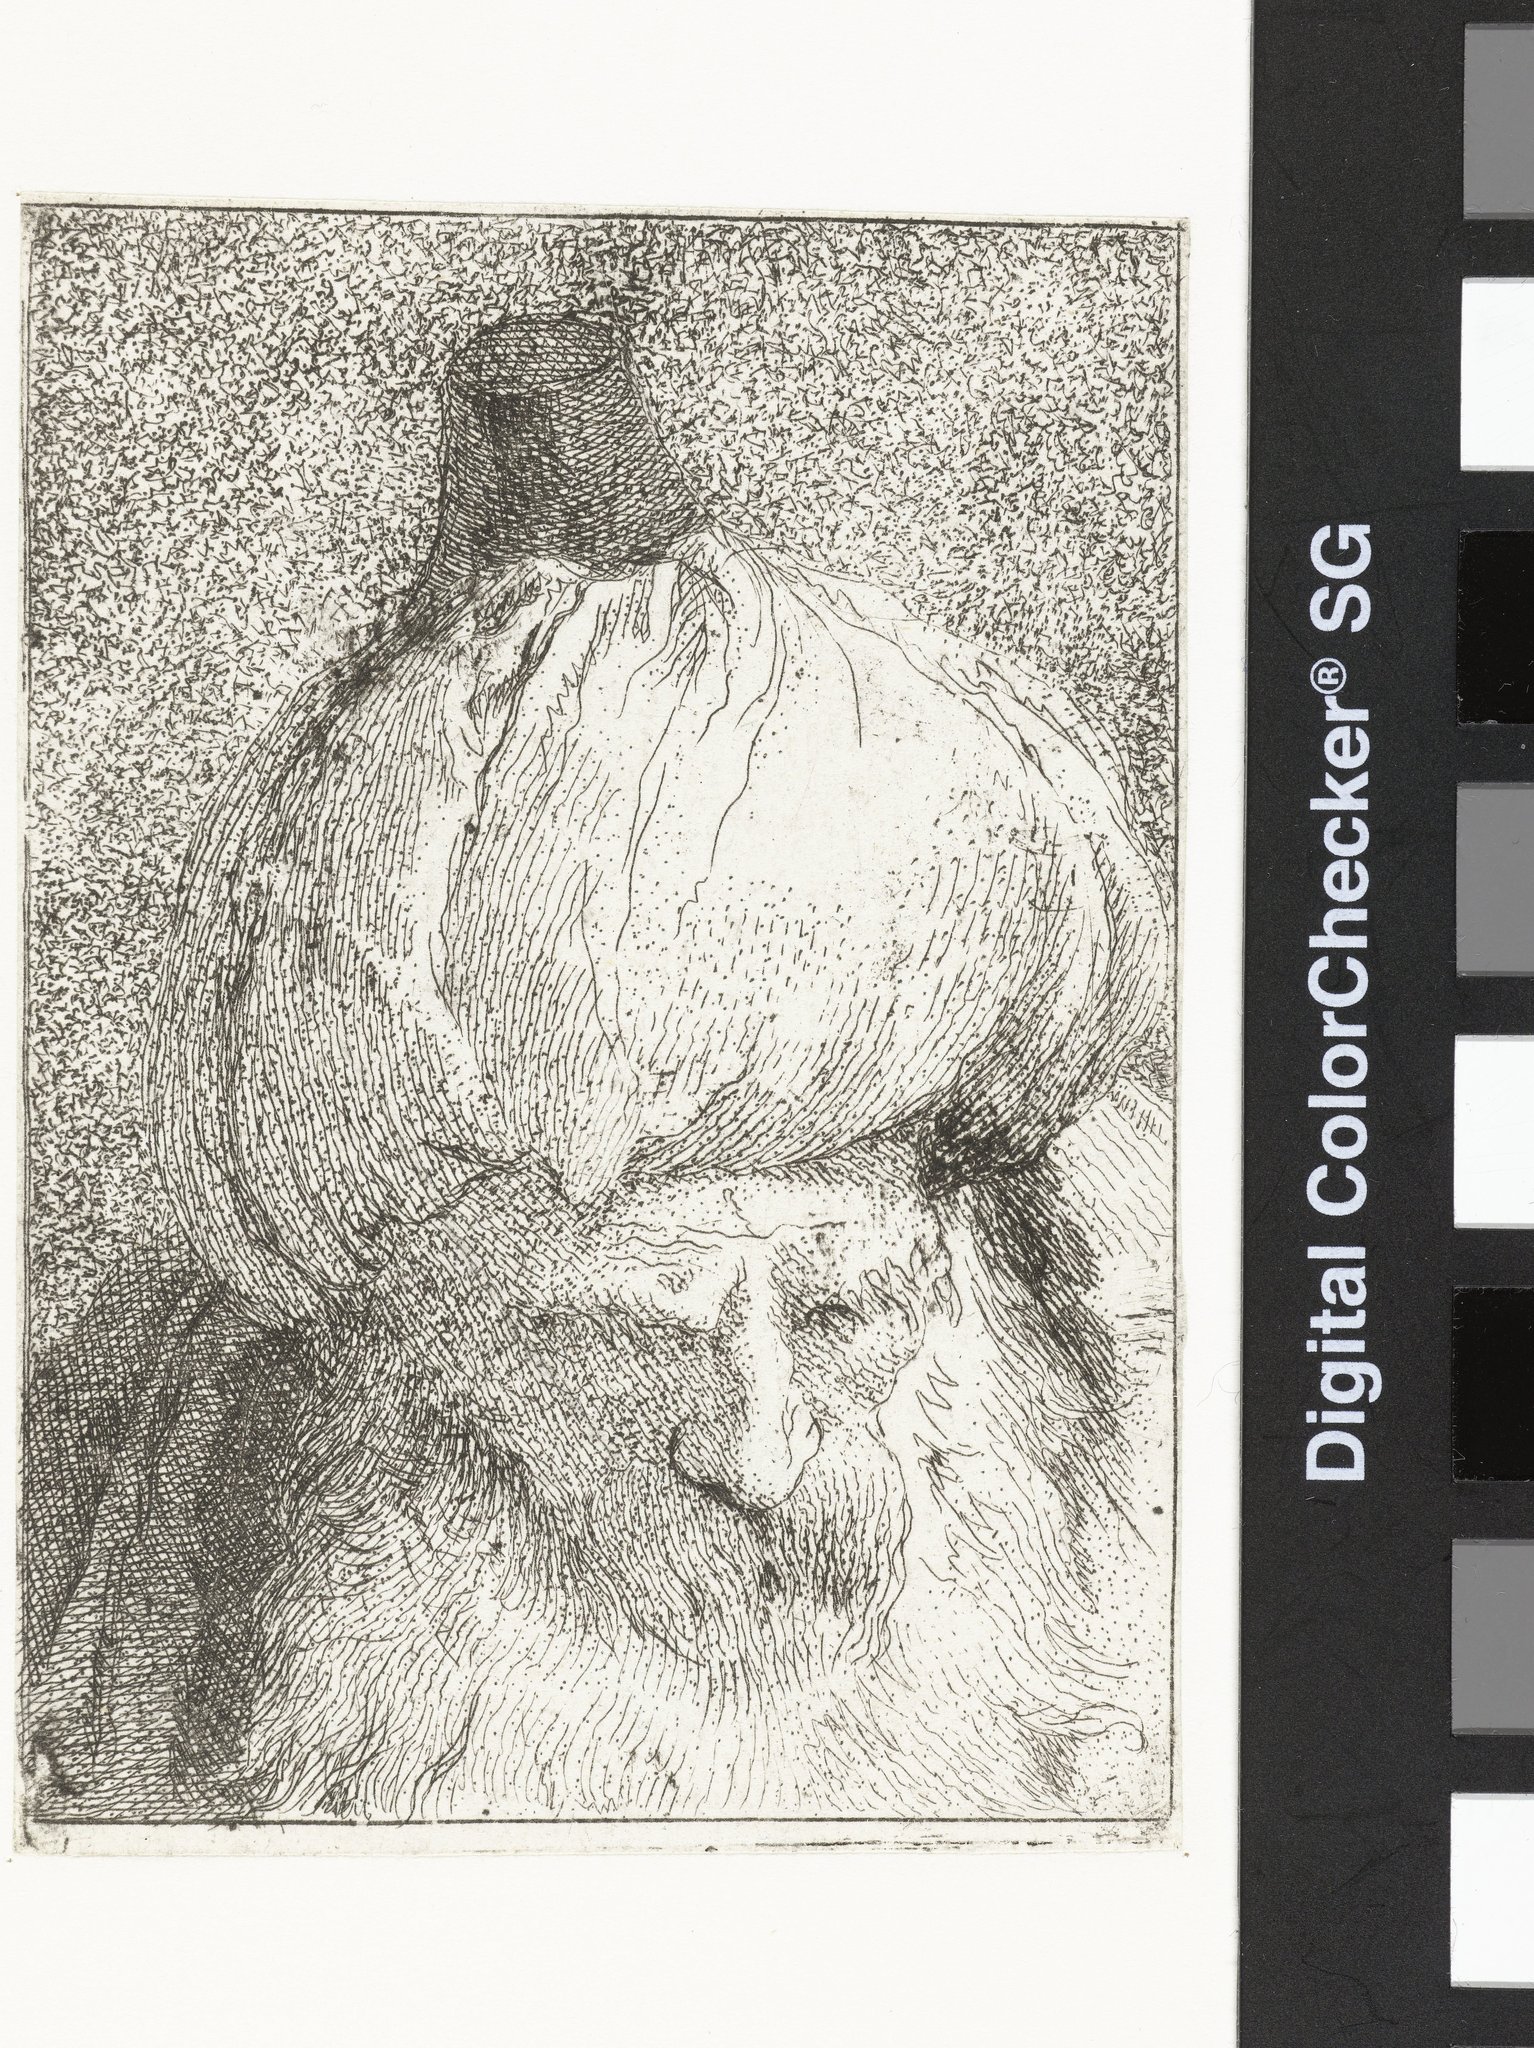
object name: print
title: Verzameling hoofden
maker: giovanni domenico tiepolo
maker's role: draughtsman, print maker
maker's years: 1727-1804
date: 1771-1774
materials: paper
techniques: etching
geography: venice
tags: head-gear: turban, person with big beard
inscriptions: collector's mark: Lugt 2228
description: Prent uit serie Verzameling hoofden (Raccolta di teste). Giovanni Domenico Tiepolo vervaardigde in de winter van 1757-1758 en in de periode van 1771-1774 deze hoofden naar schilderijen en tekeningen van Giovanni Battista Tiepolo. De eerste uitgave verscheen in 1774 in twee delen met elk dertig prenten. Deze prent werd in de tweede staat met serienummer 9 opgenomen in deel 2.